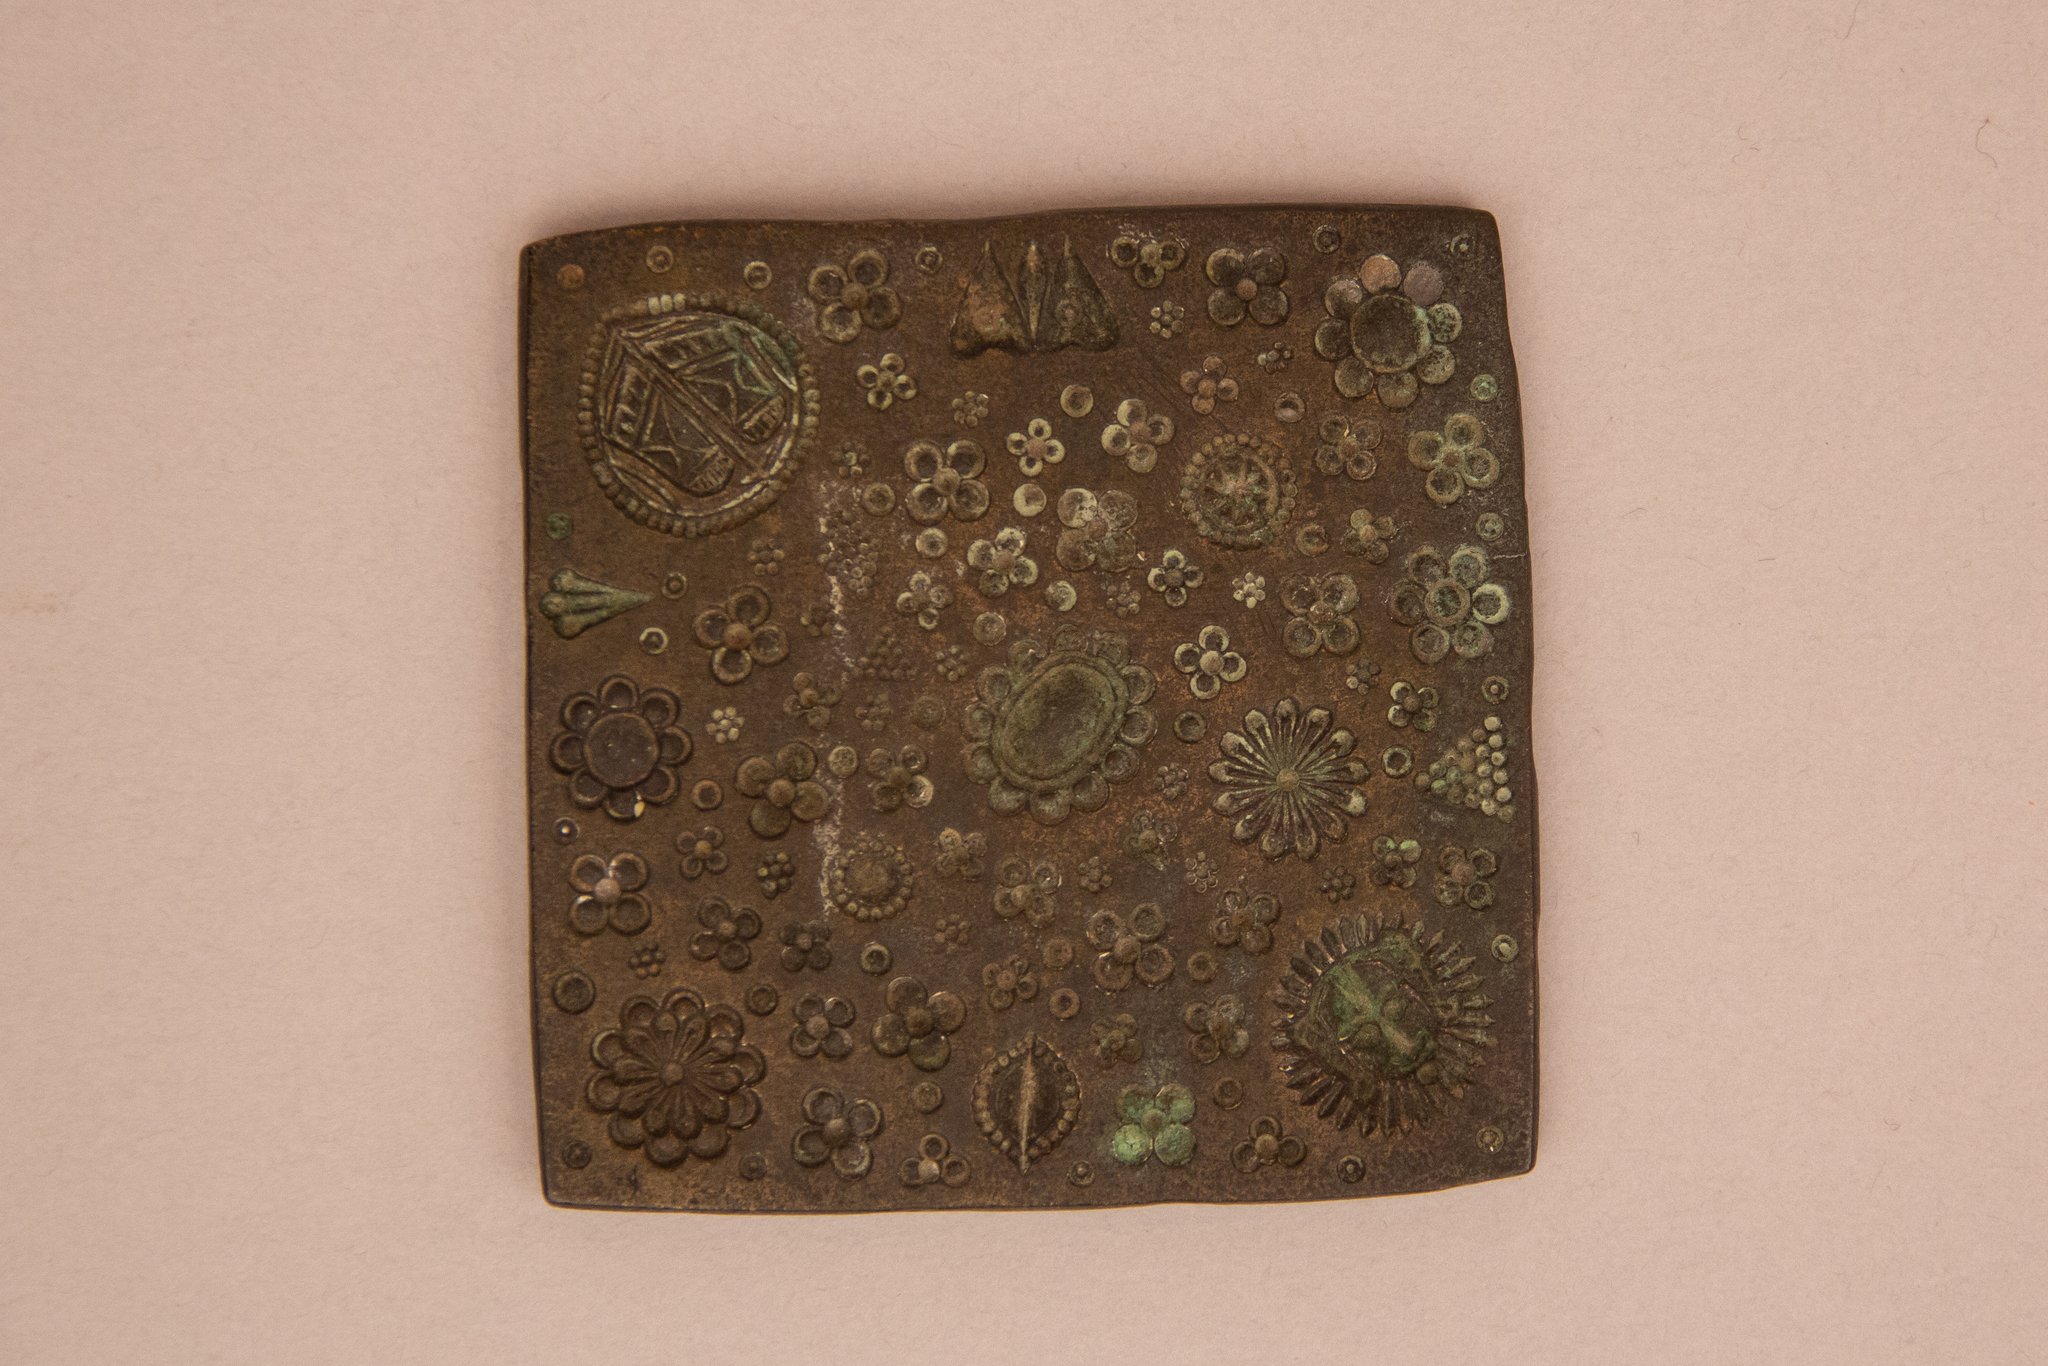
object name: jewelry mold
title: Mold for Making Jewelry (Chhapa)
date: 901-1100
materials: brass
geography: india